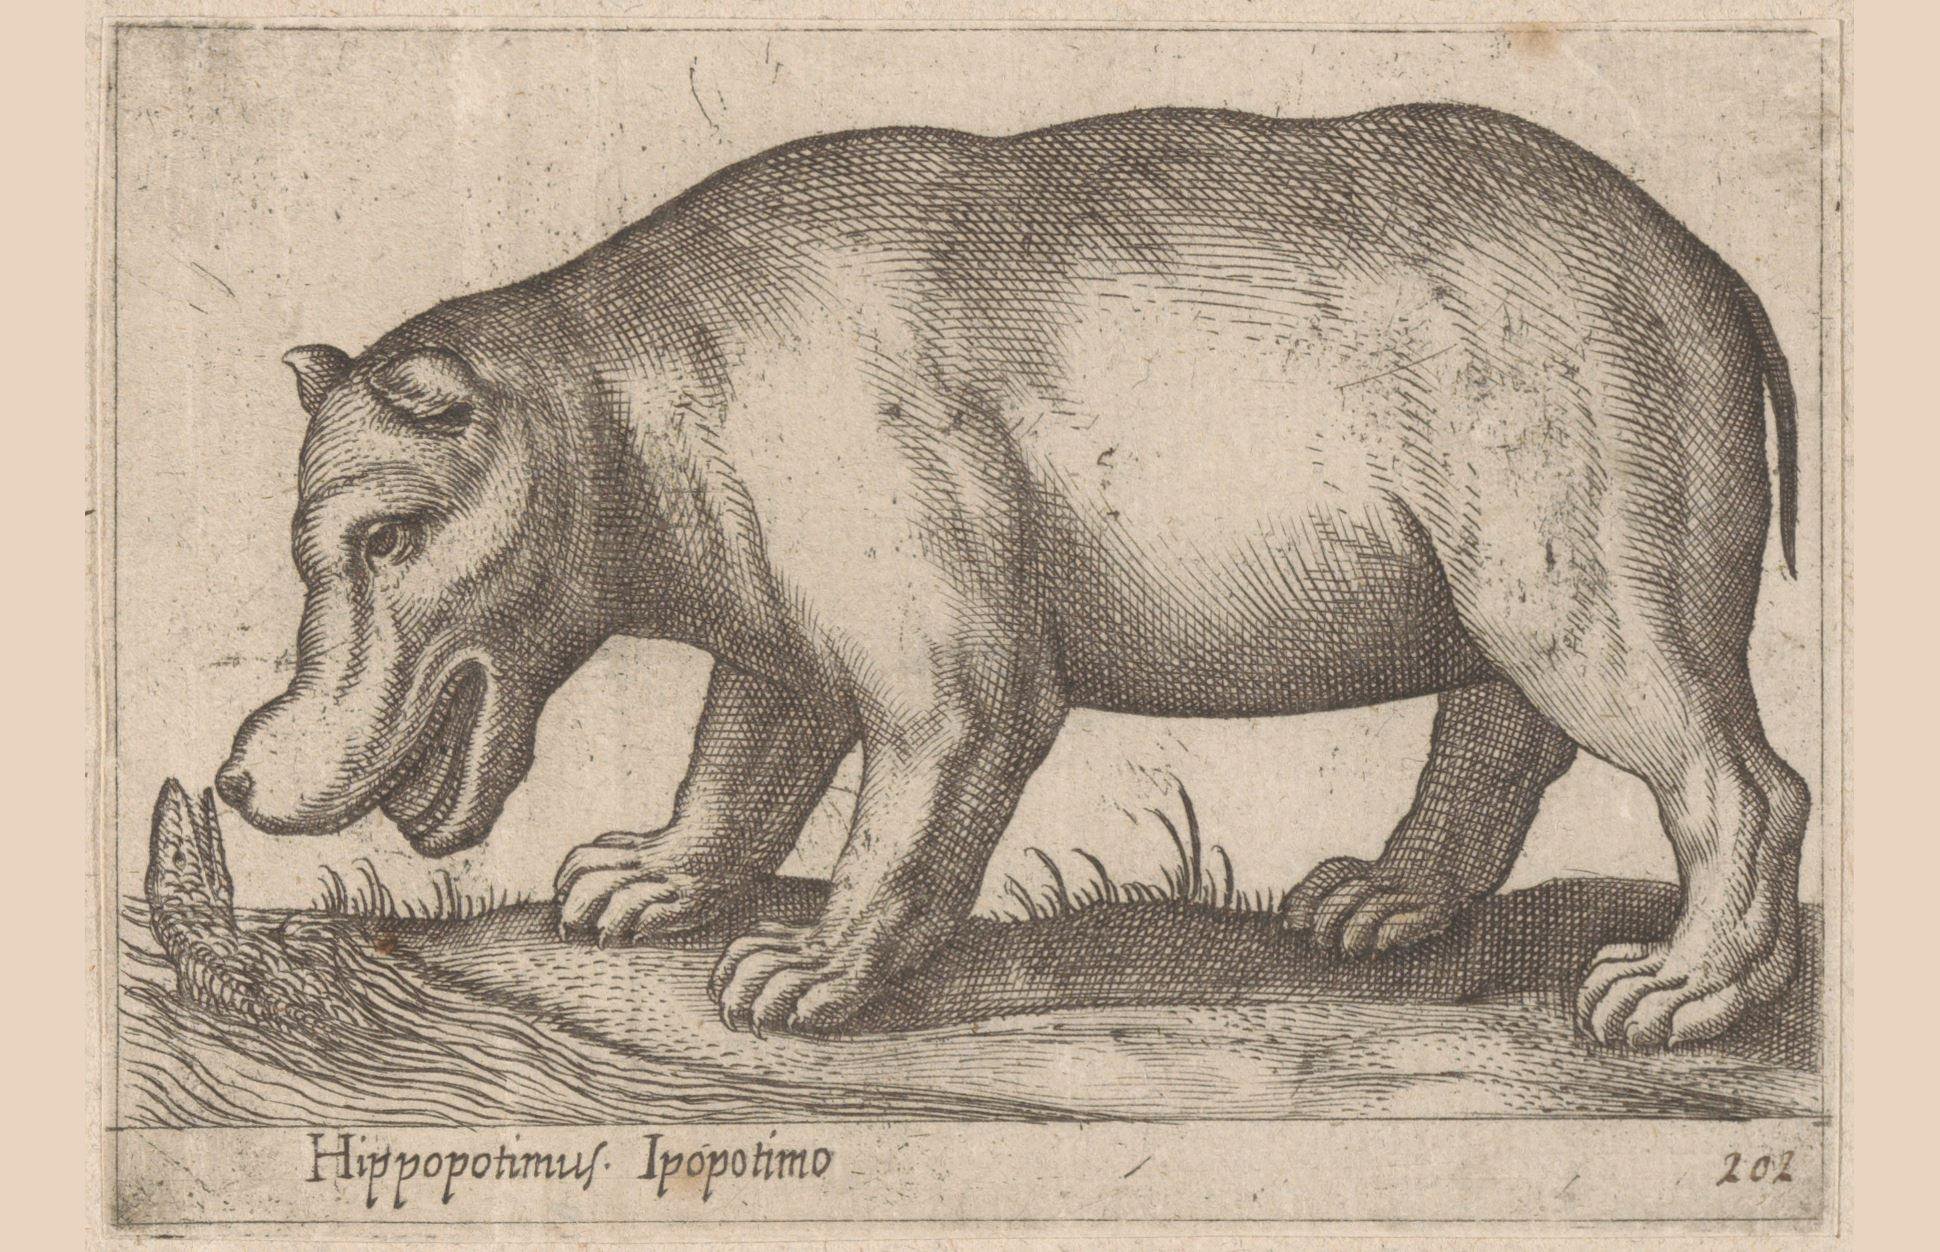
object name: print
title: Dieren en fabelwezens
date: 1565-1630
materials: paper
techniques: etching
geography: rome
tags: hoofed animals: hippopotamus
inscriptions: number: ‘202’, collector's mark: Lugt 11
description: Deze prent maakt deel uit van een reeks prenten van dieren door Antonio Tempesta. Bekend is dat een tweede staat (met nummering) van deze serie is uitgegeven door Giovanni Giacomo de' Rossi in 1650. Onbekend is wie de eerste staat heeft uitgegeven en wanneer.